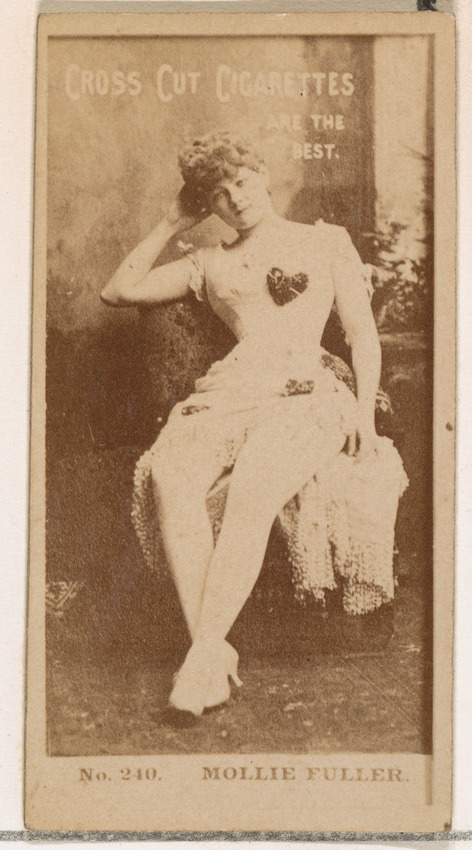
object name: print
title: Card Number 240, Miss Fuller, from the Actors and Actresses series (N145-2) issued by Duke Sons & Co. to promote Cross Cut Cigarettes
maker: w. duke, sons & co.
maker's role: publisher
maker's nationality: american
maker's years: 1870-1920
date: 1880-1889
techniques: albumen silver print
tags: portraits,women,actresses